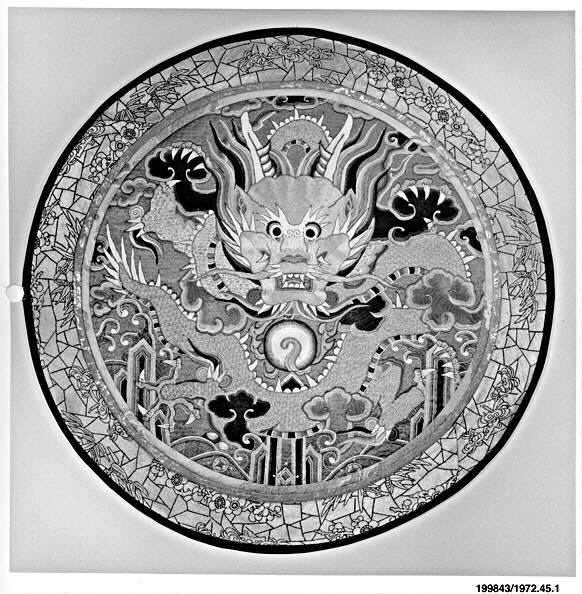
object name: roundel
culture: chinese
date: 1368-1644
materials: gold thread, silk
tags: dragons